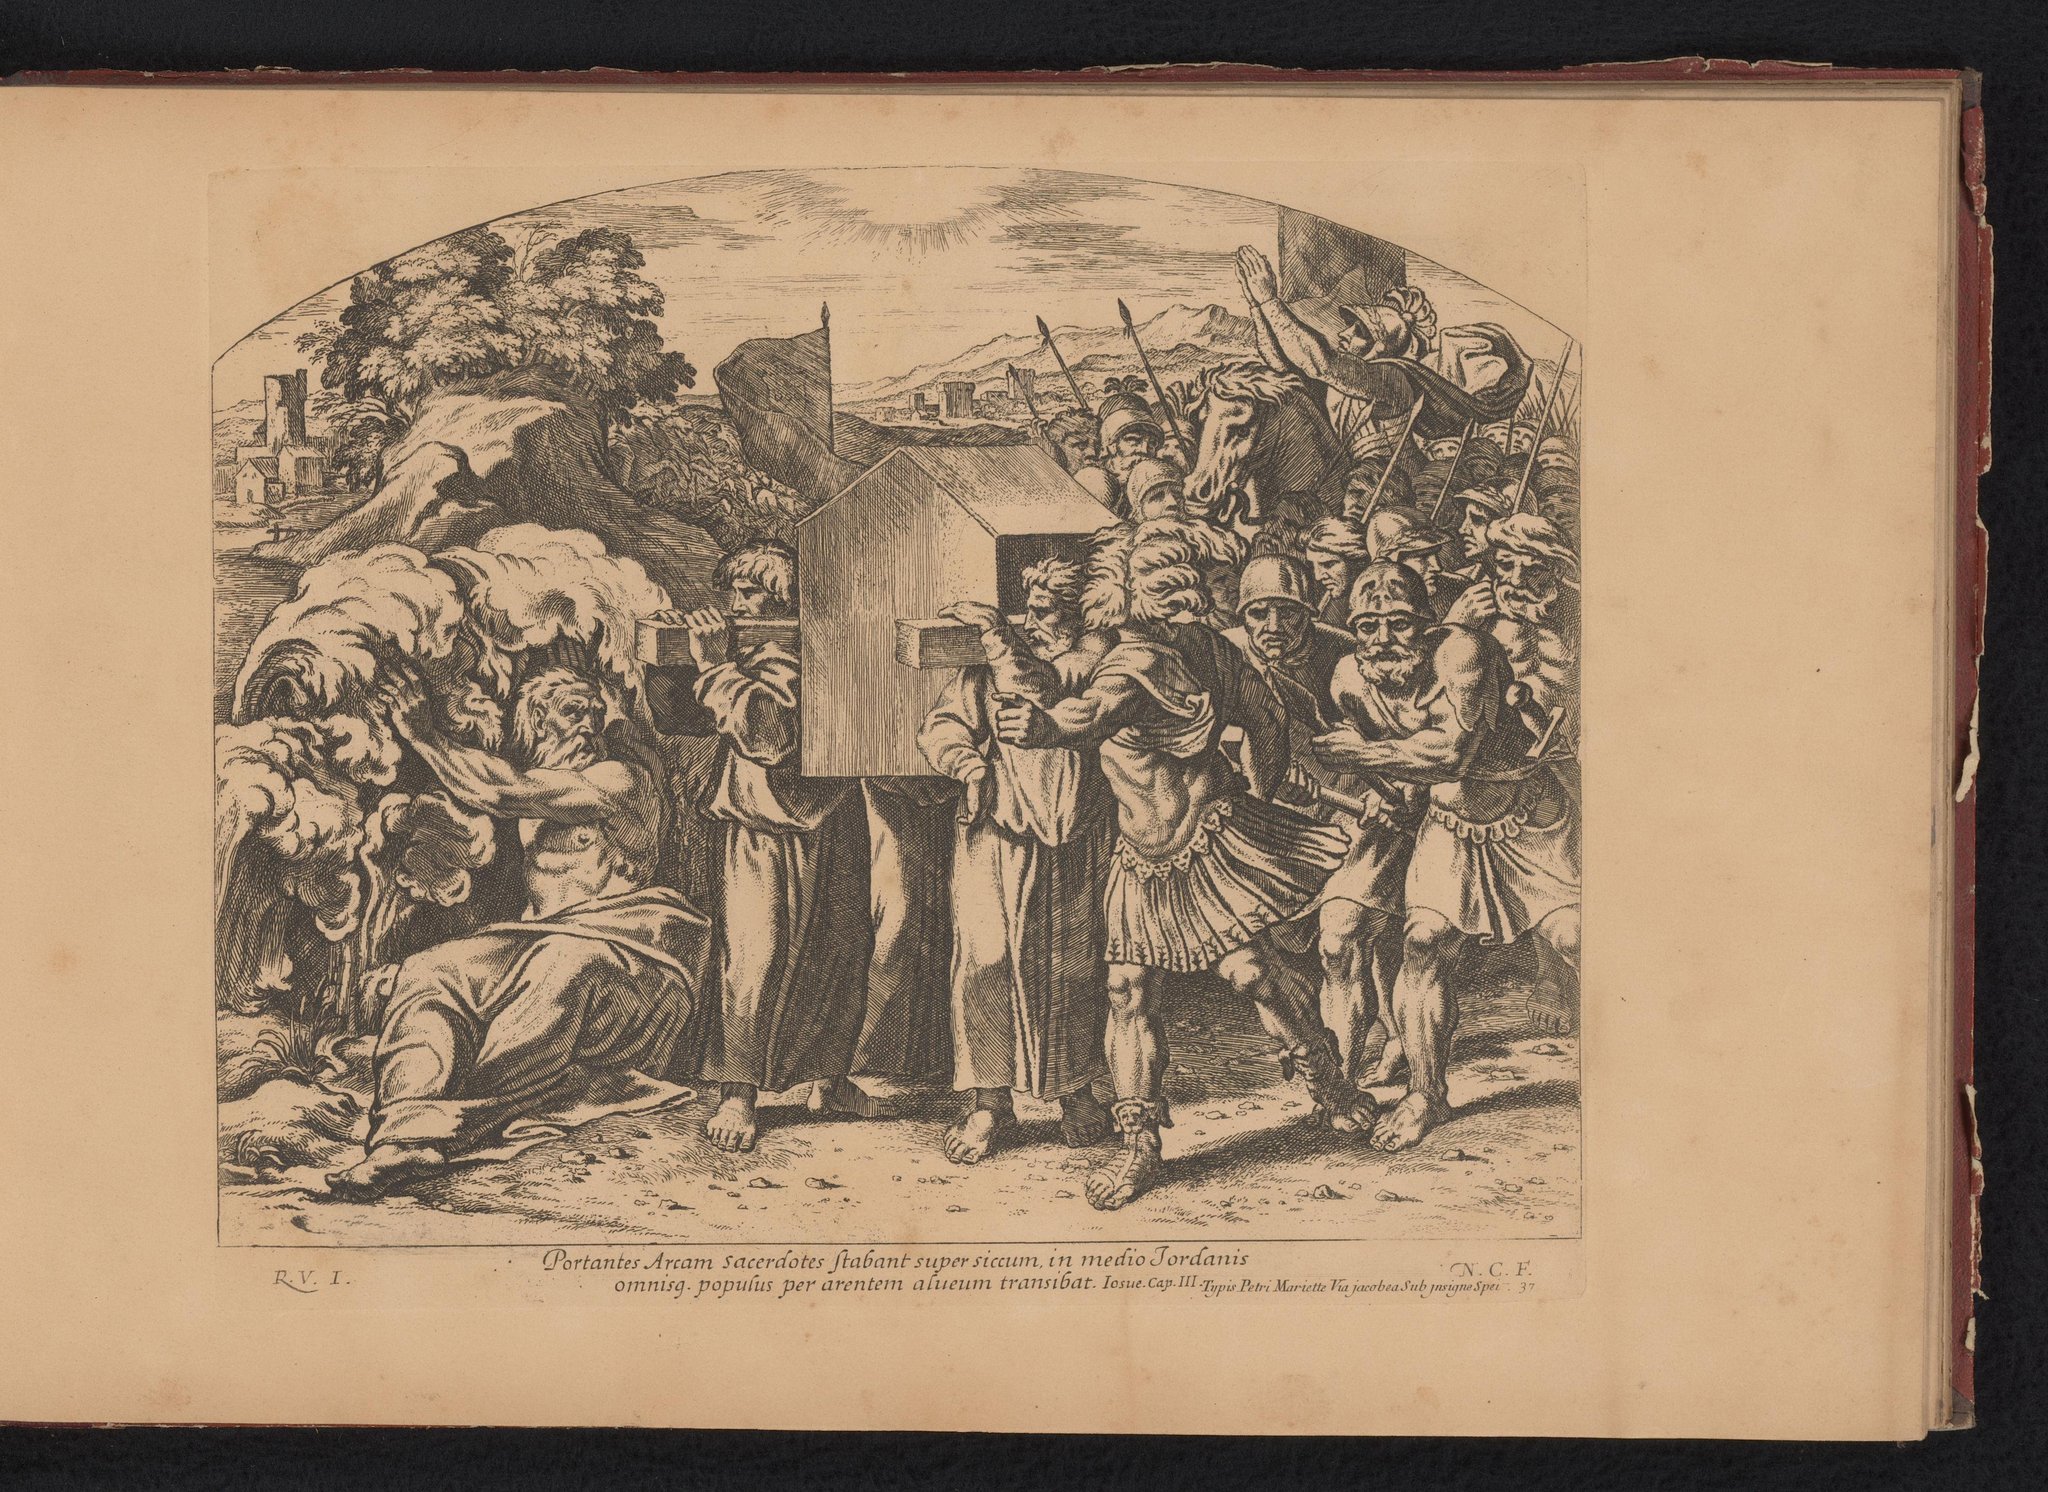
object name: print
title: Mozes toont de tafelen der wet aan het volk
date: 1649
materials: paper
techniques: etching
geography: paris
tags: moses comes down with the new tablets and is awaited by aaron and the assembled people, who notice that 'his face is shining' (moses' face is depicted with rays of light or with horns), moses on mount sinai with the tables of the law (exodus 24:9-18, 31:18)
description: Deze prent maakt deel uit van een album.